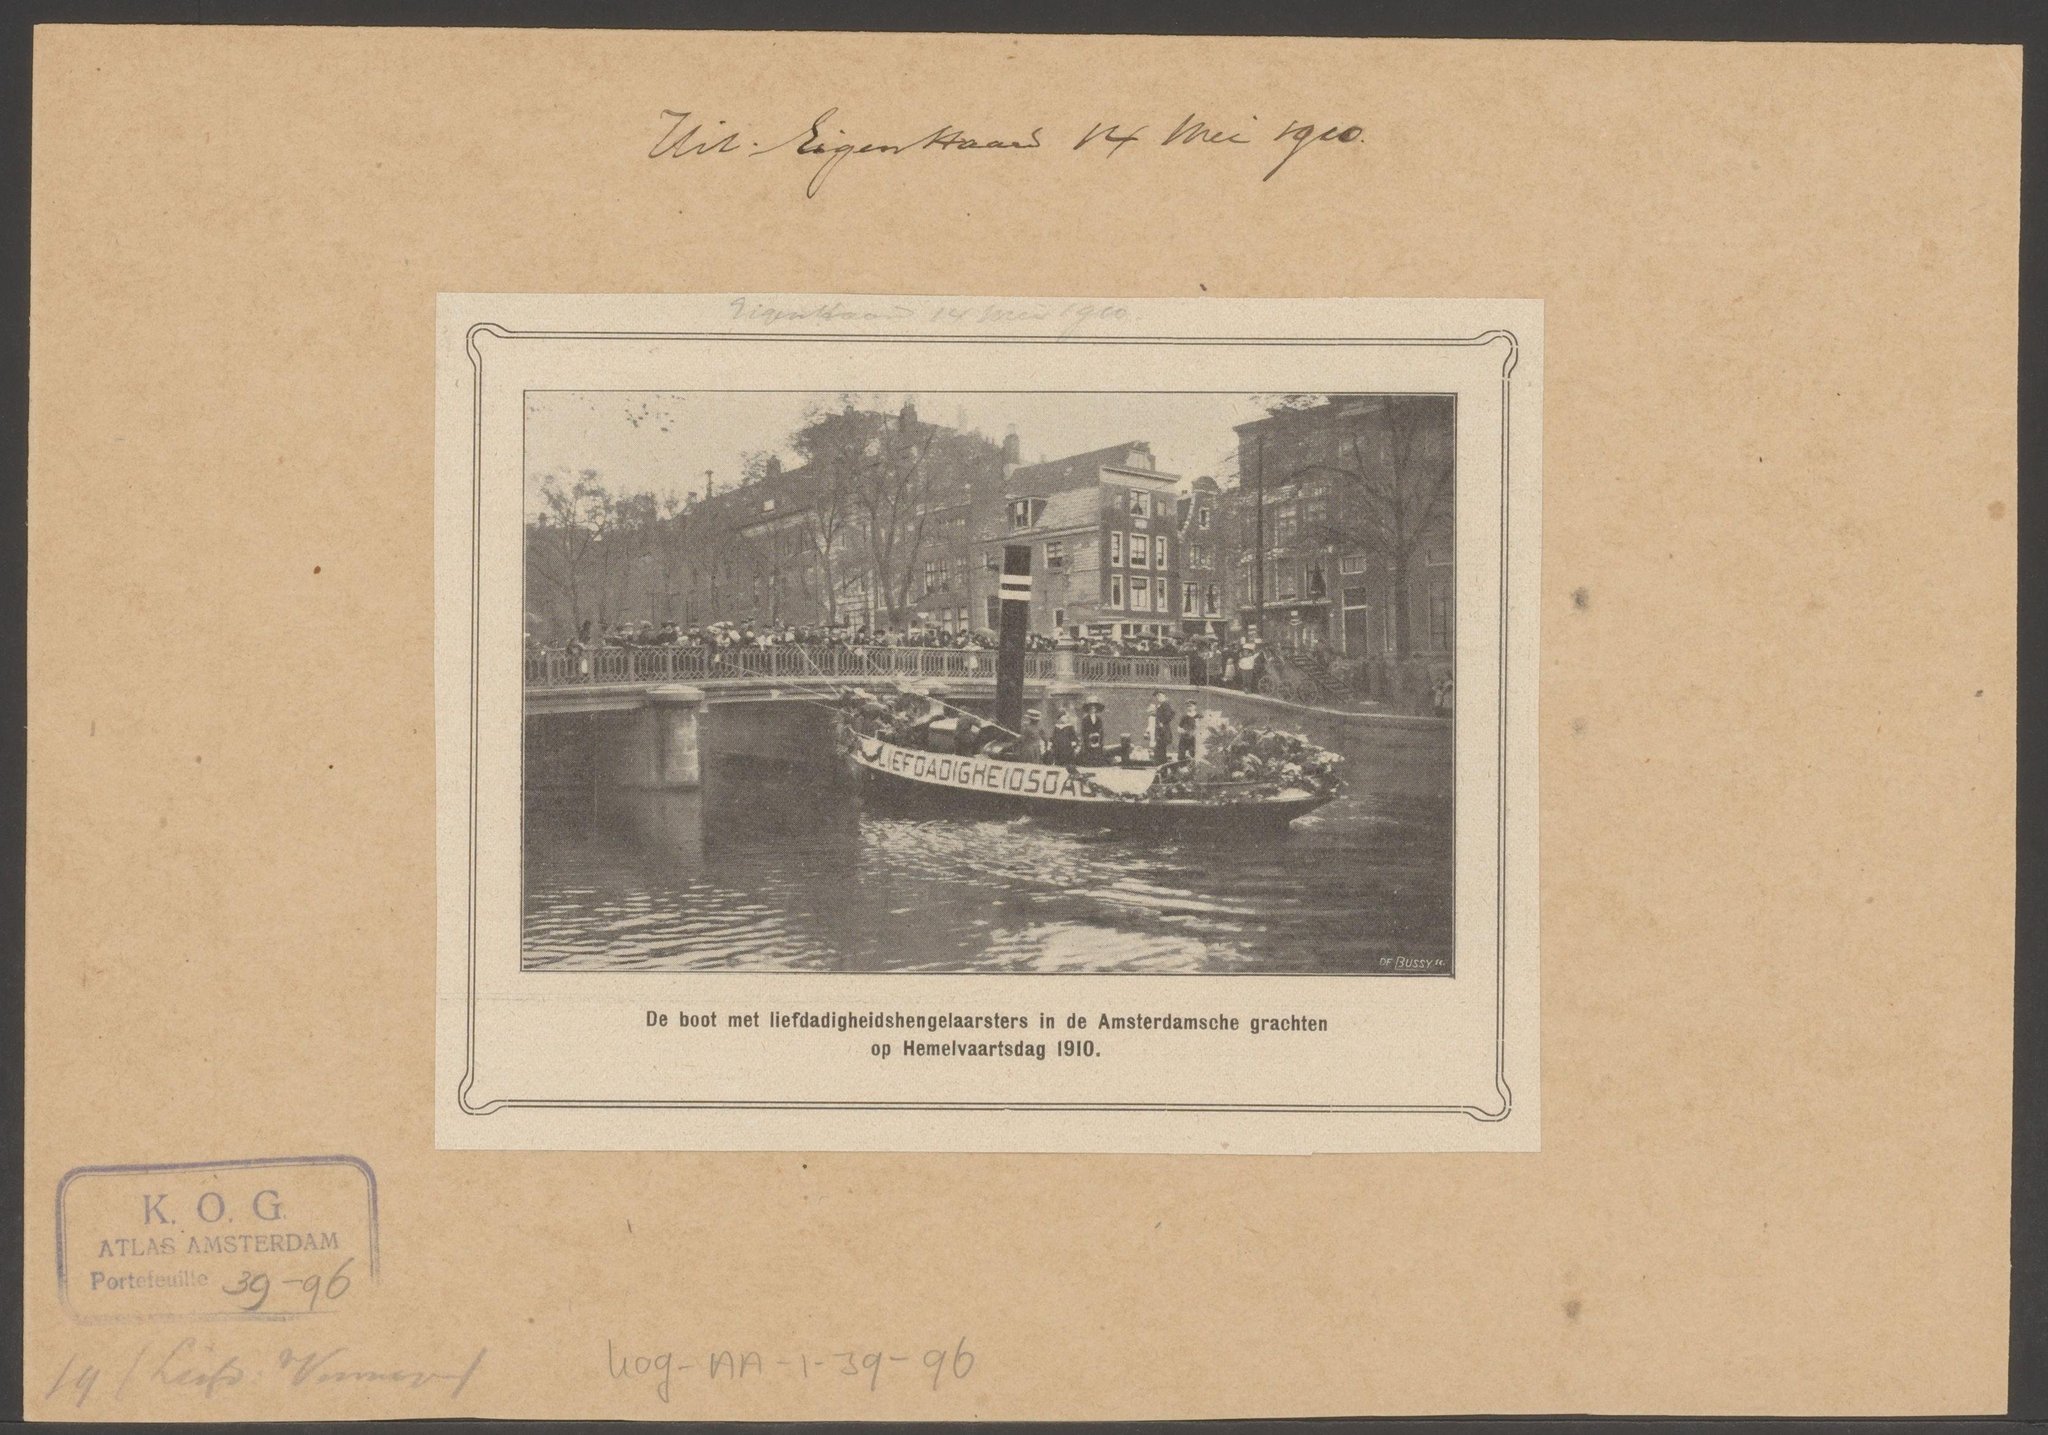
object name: photomechanical print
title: Versierde boot op een gracht te Amsterdam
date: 1910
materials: paper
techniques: letterpress printing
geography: amsterdam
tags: bridge in city across river, canal, etc. (+ city(-scape) with figures, staffage), canals, waters (in city) (+ city(-scape) with figures, staffage), steamship, motorship, amsterdam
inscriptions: collector's mark: Lugt 1641b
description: Onderwerpsrubriek binnen de Atlas Amsterdam: Armwezen en liefdadige instellingen: III. Verschillende gestichten en instellingen / Hofjes: Liefdadigheid naar Vermogen.